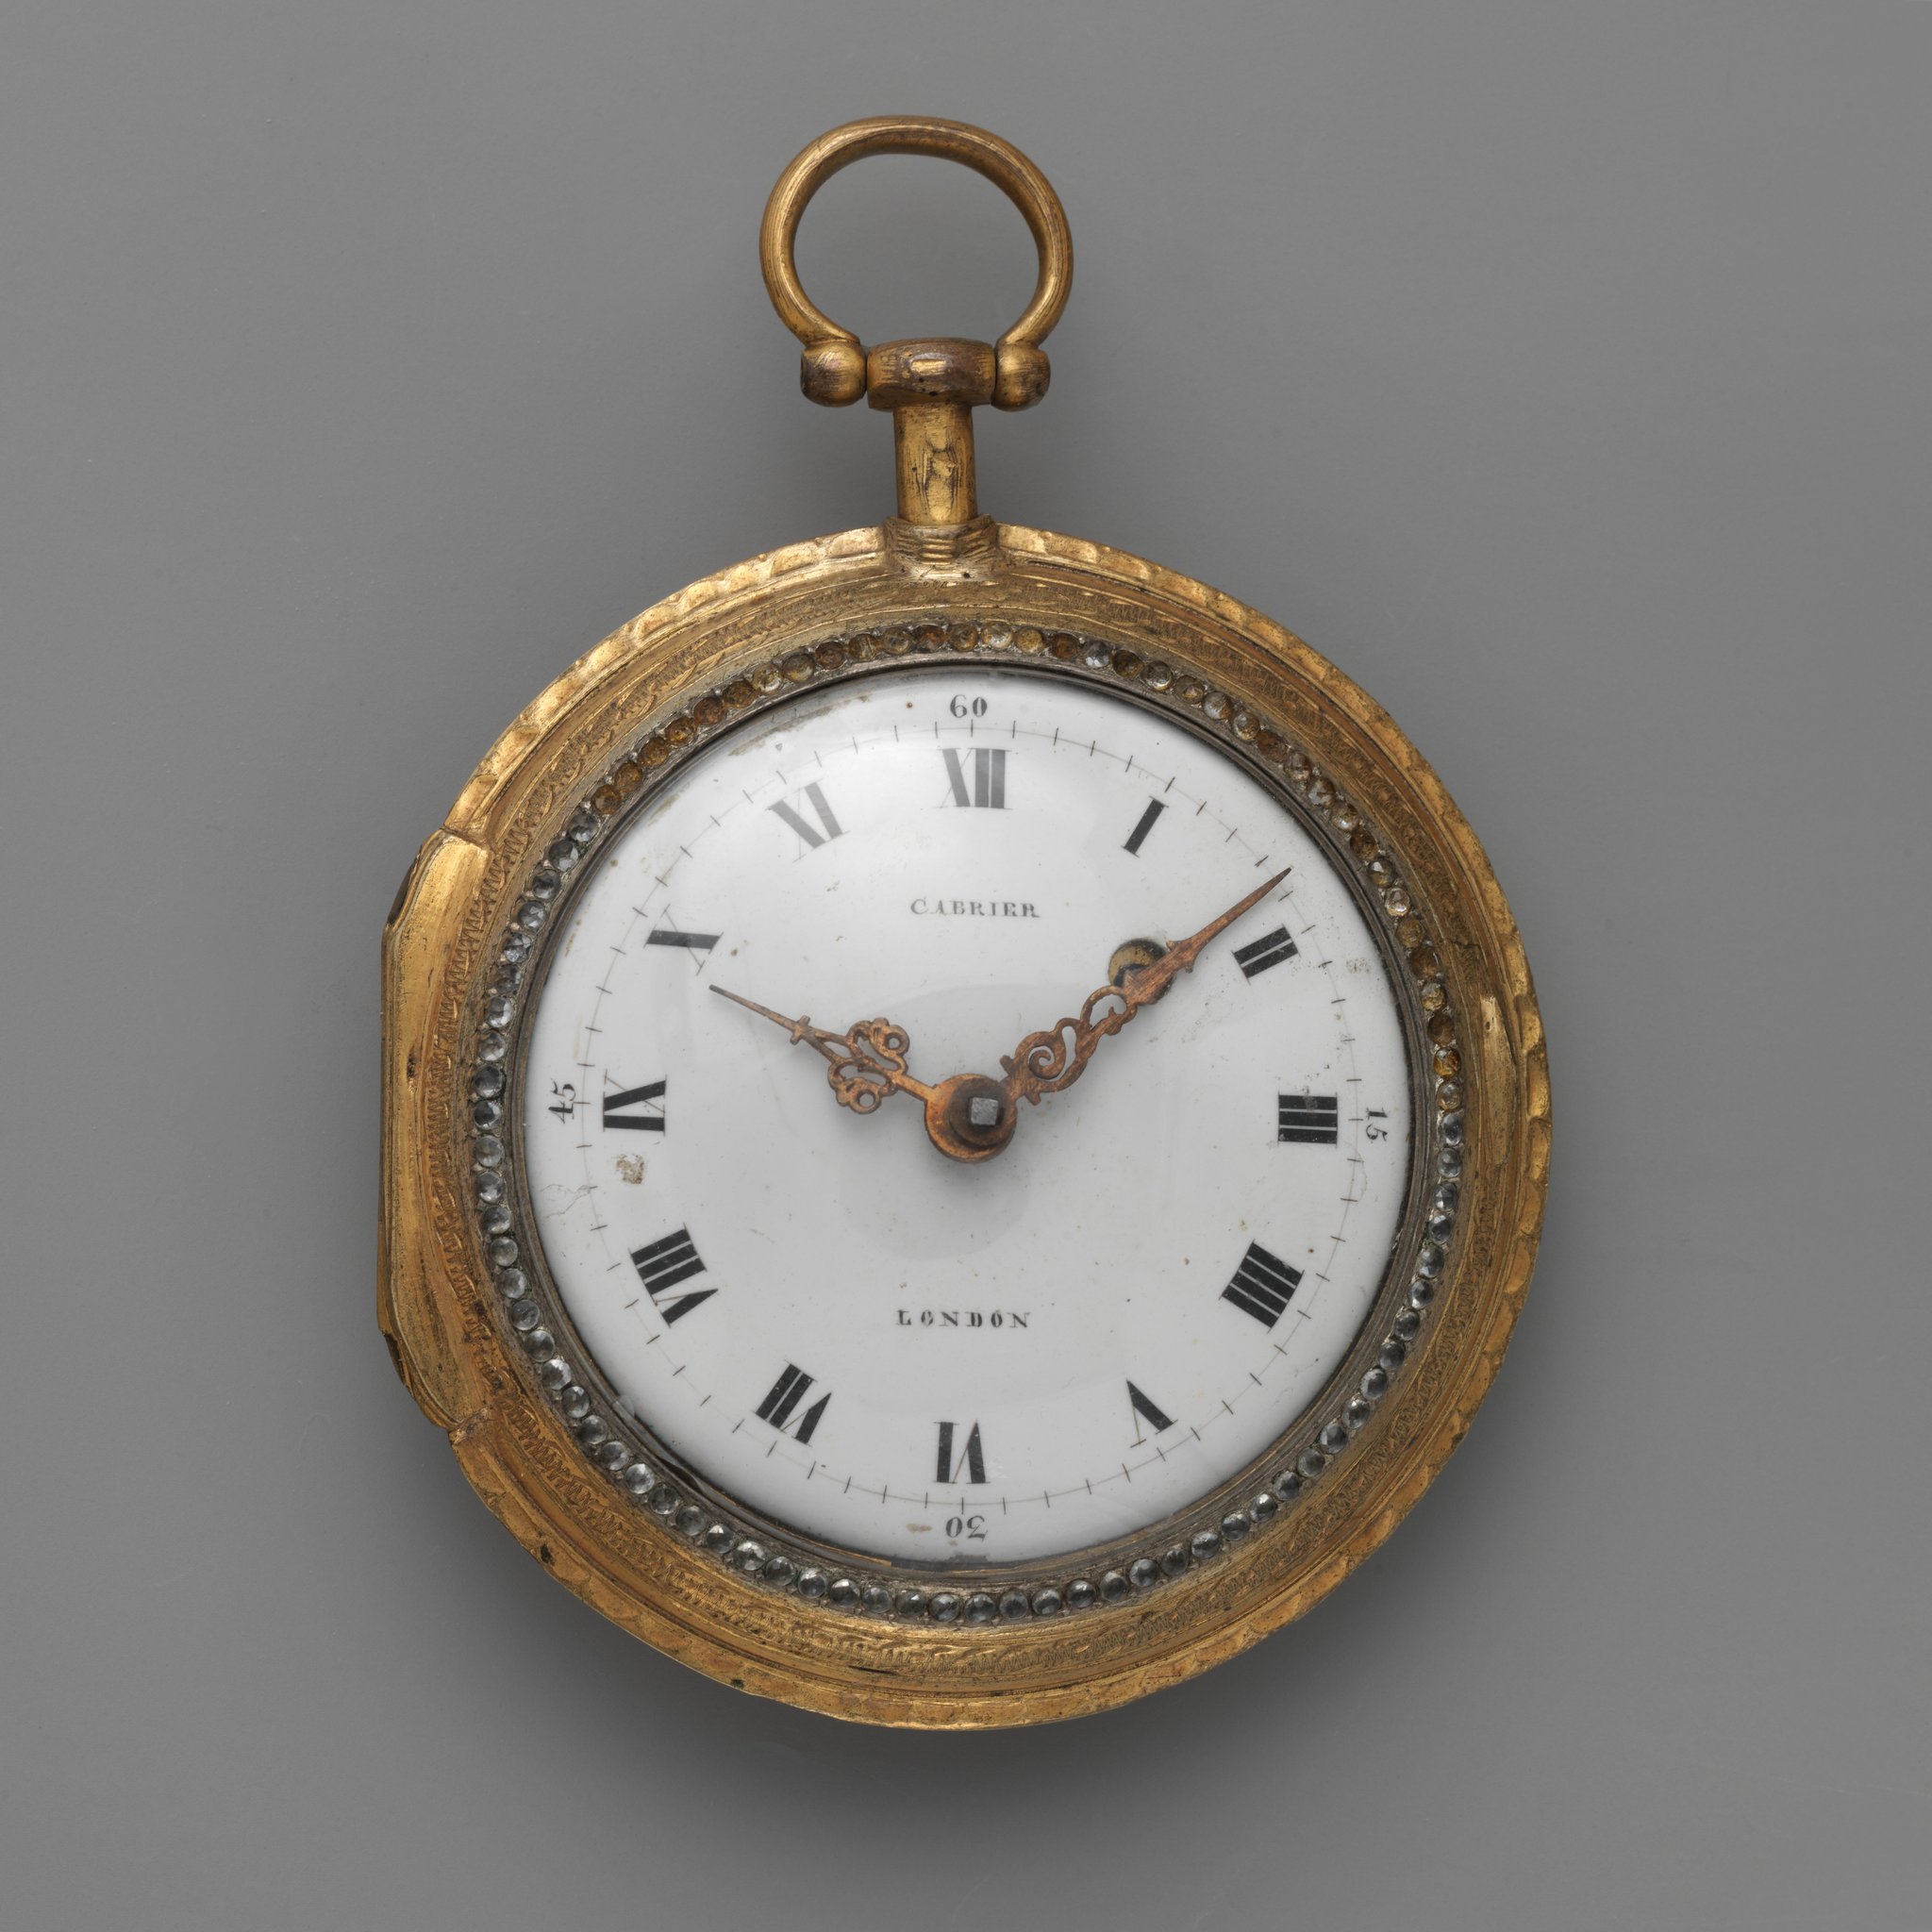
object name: watch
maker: charles cabrier ii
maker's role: maker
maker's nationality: british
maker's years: 1719-1776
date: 1740-1760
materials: paste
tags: docks,ships